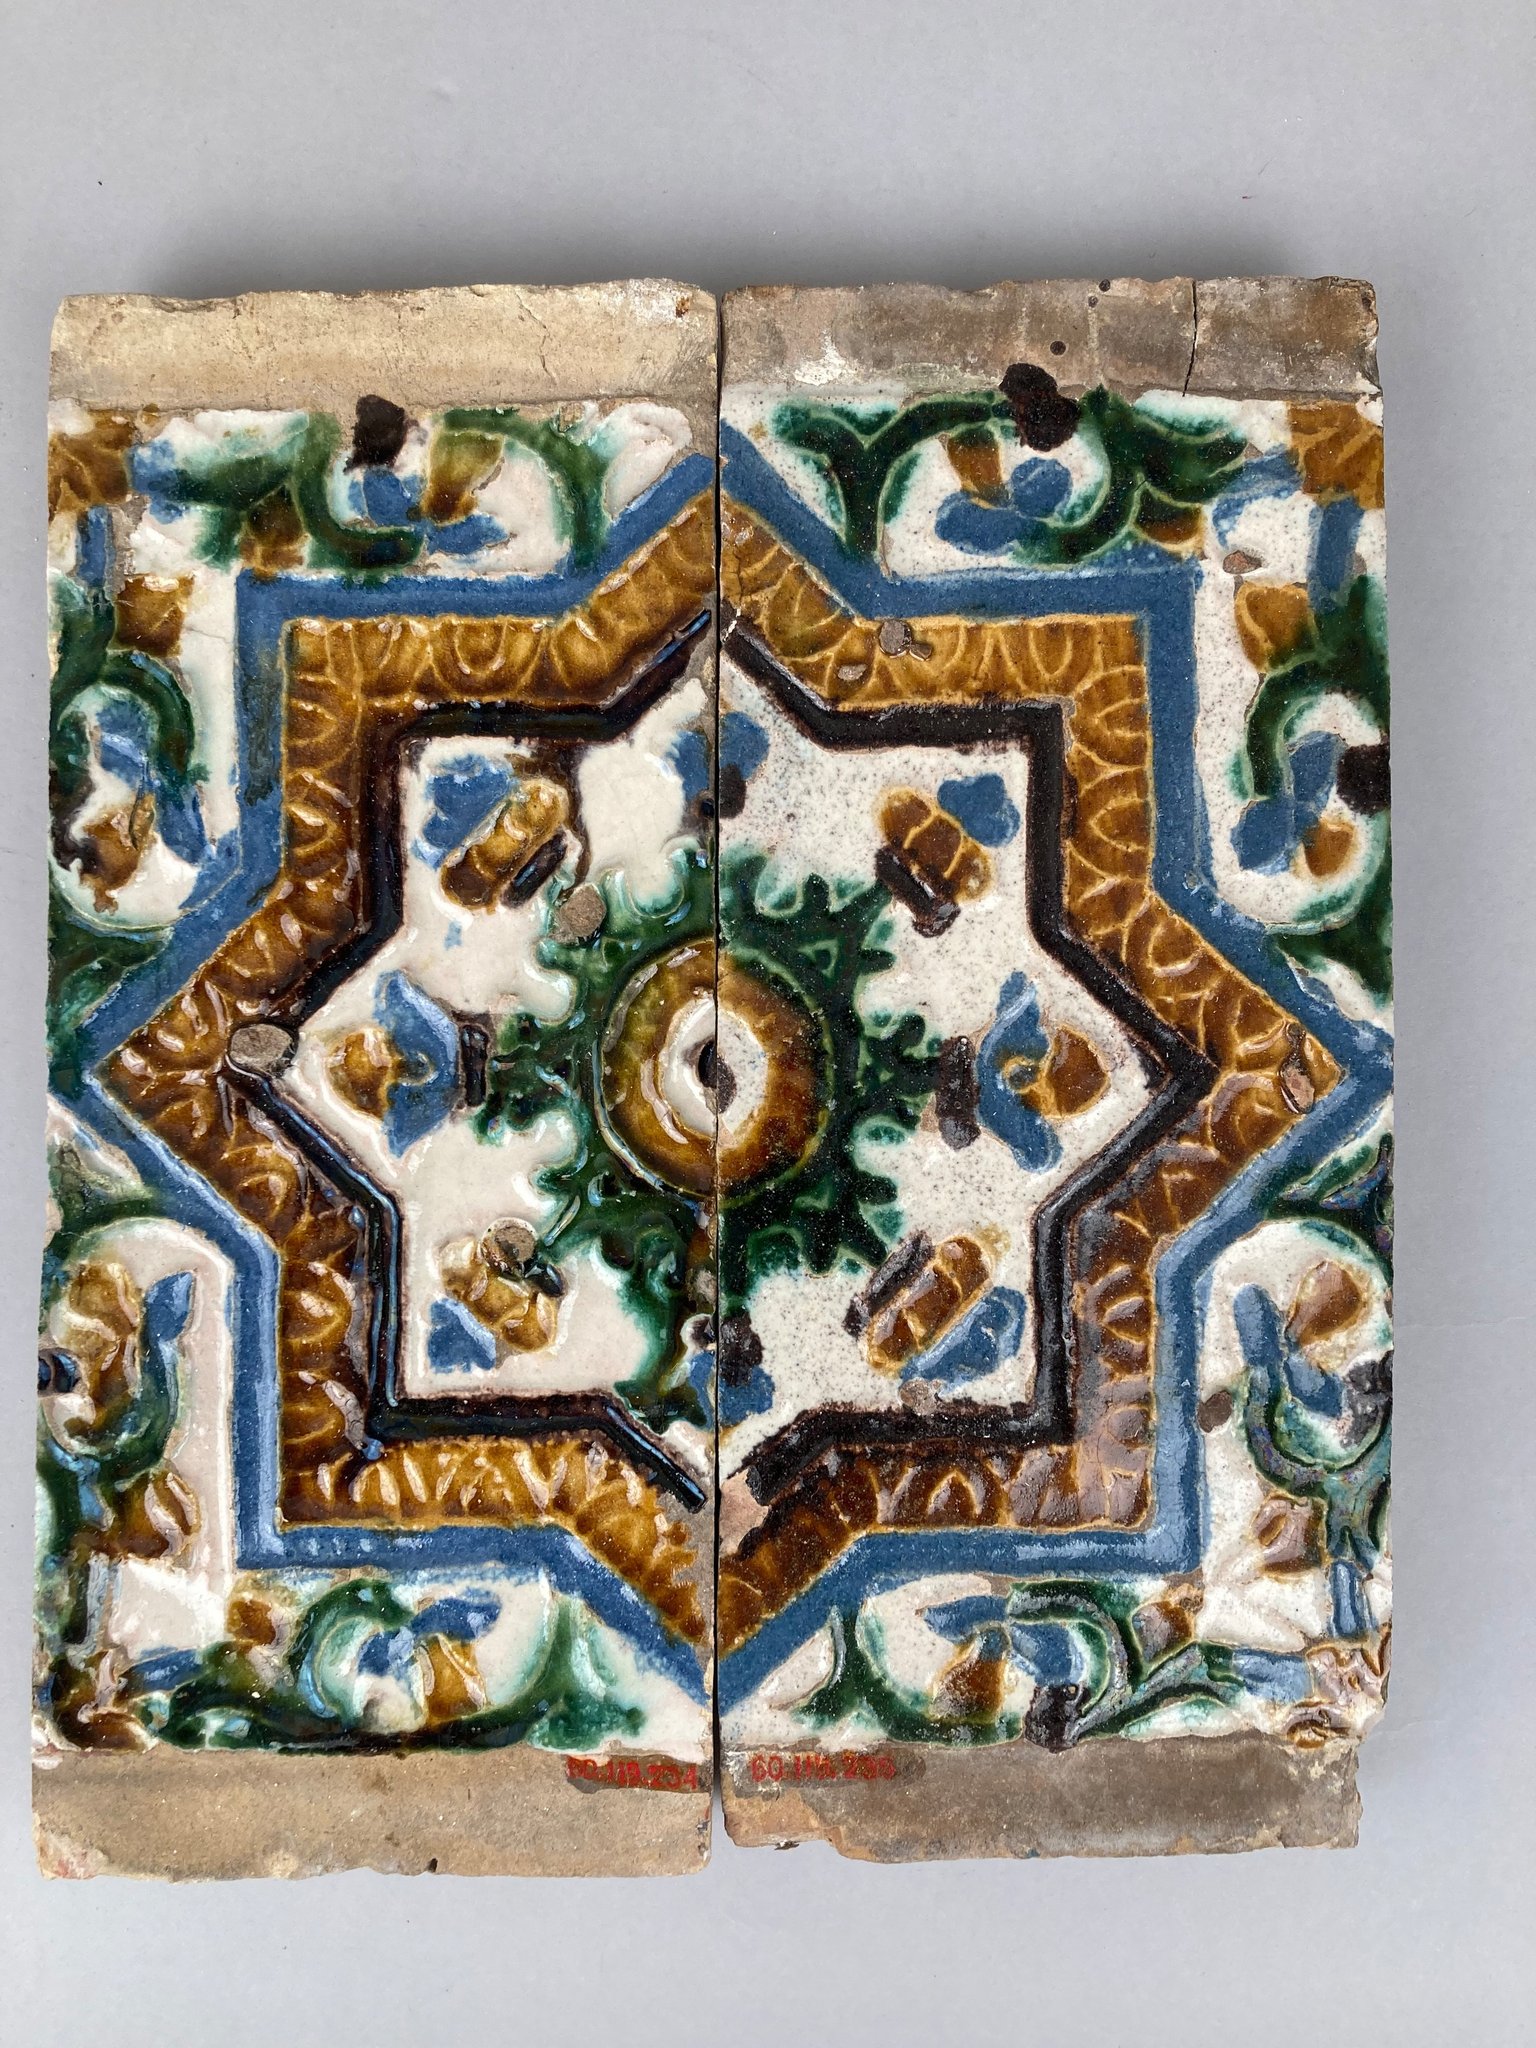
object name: ceiling tile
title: Ceiling tiles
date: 1534-1566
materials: earthenware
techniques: glazing